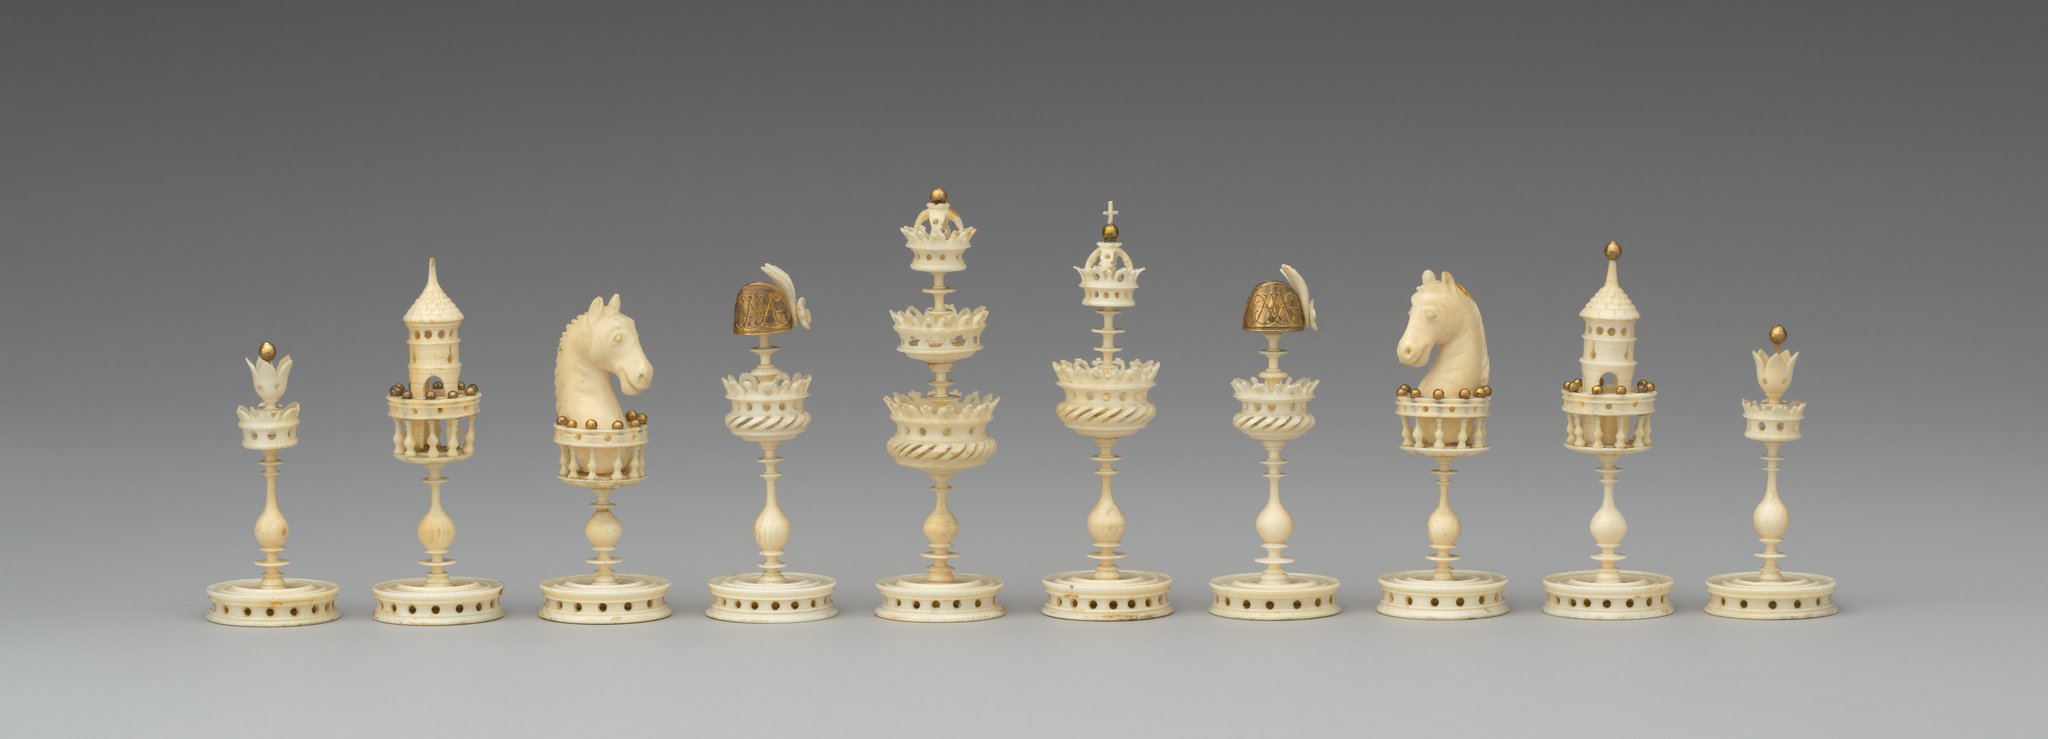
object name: chessman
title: Chessmen (32)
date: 1767-1833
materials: brass, gilt, ivory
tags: chess